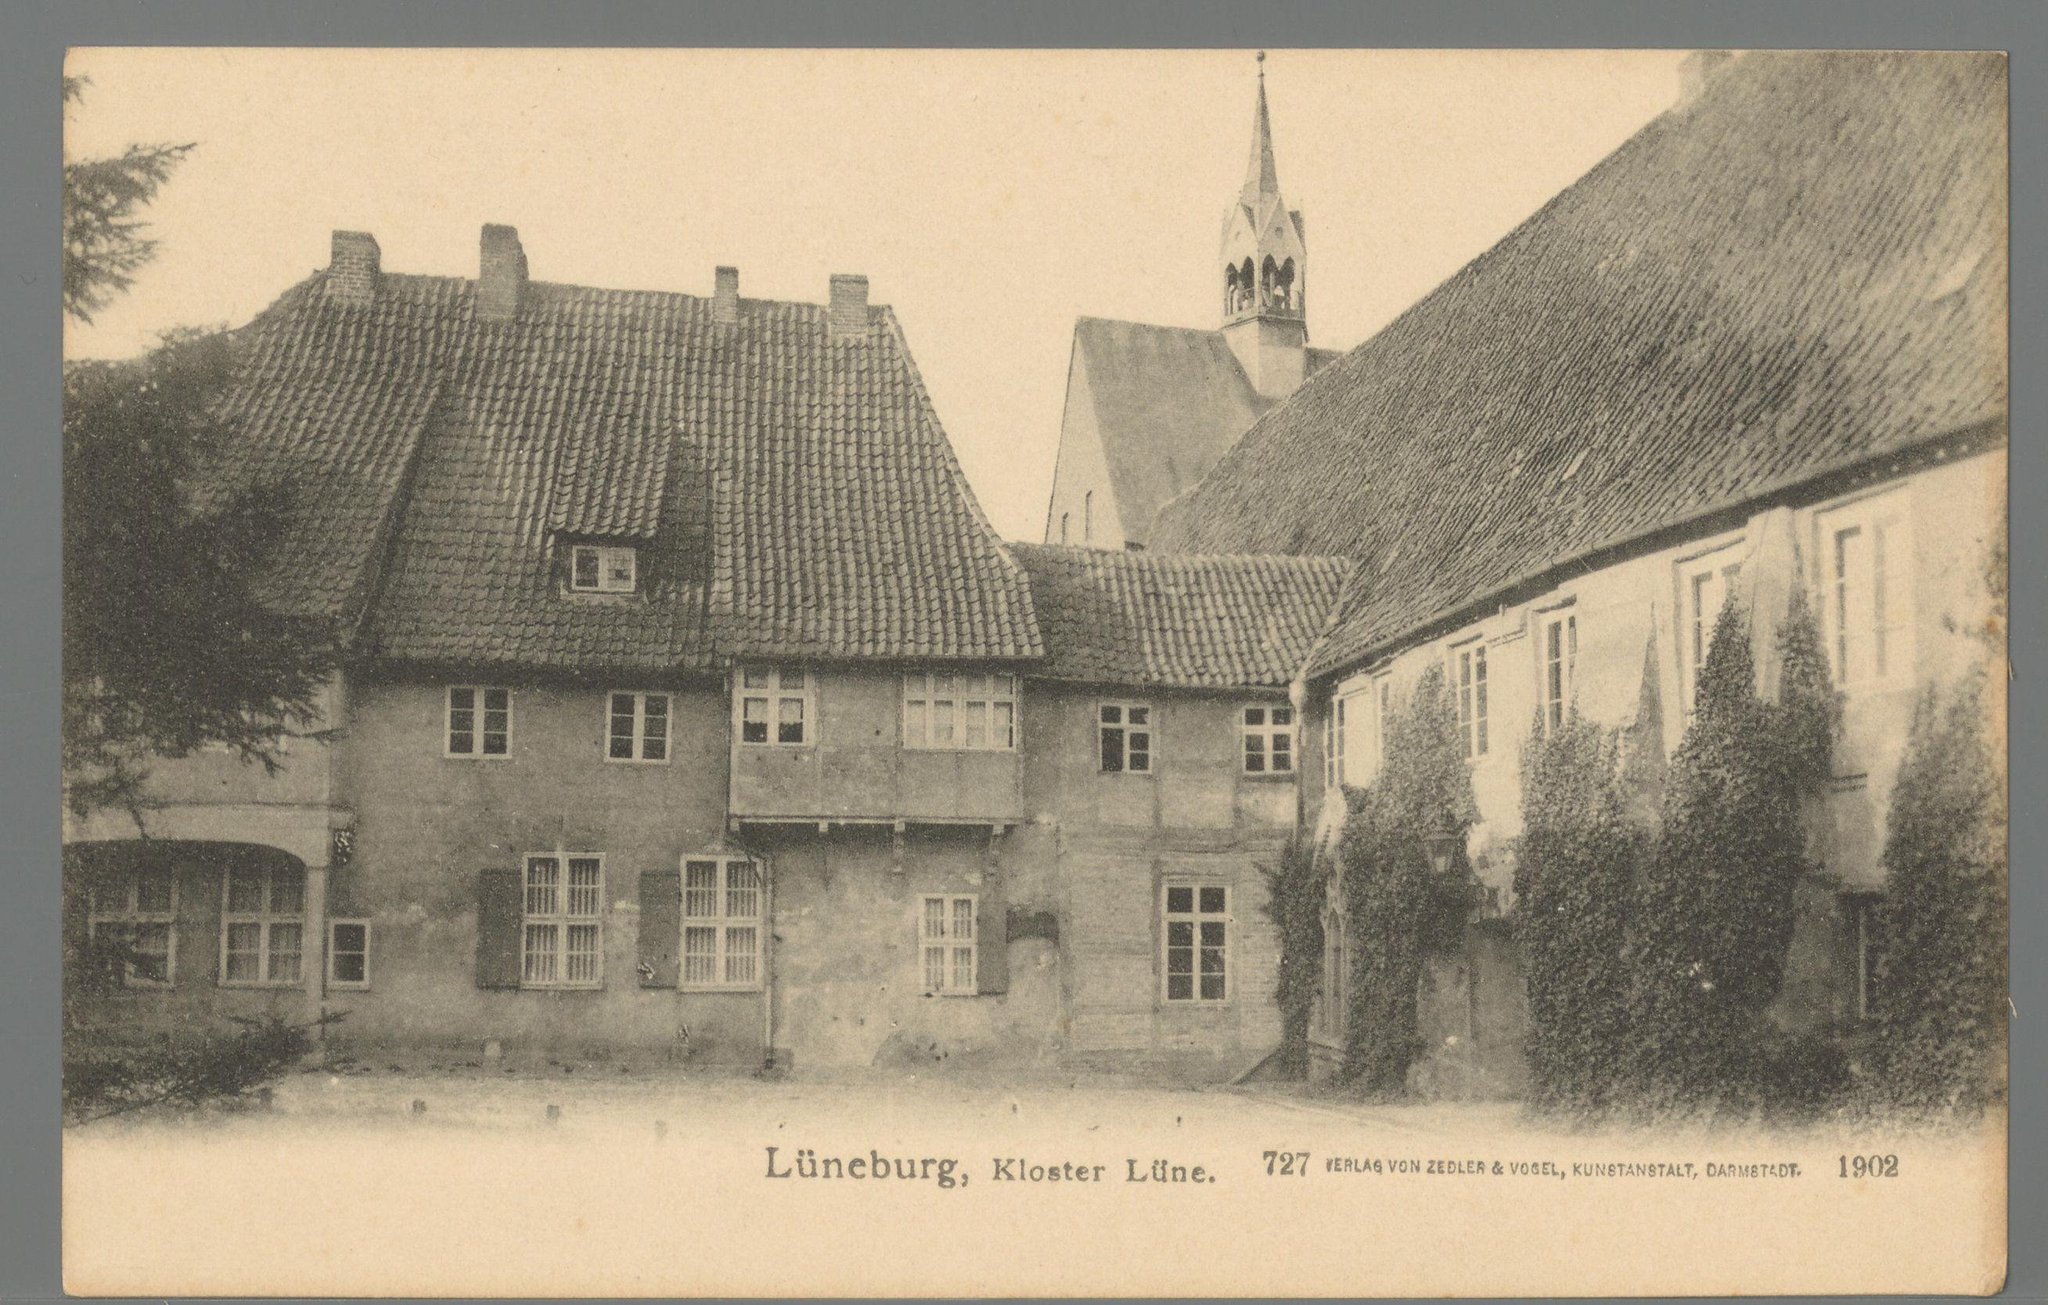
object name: ansichtkaart, prentbriefkaart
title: Lüneburg, Kloster Lüne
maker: Anonymous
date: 1902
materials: cardboard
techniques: photograph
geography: darmstadt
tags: abbey, monastery, convent ~ roman catholic church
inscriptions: date